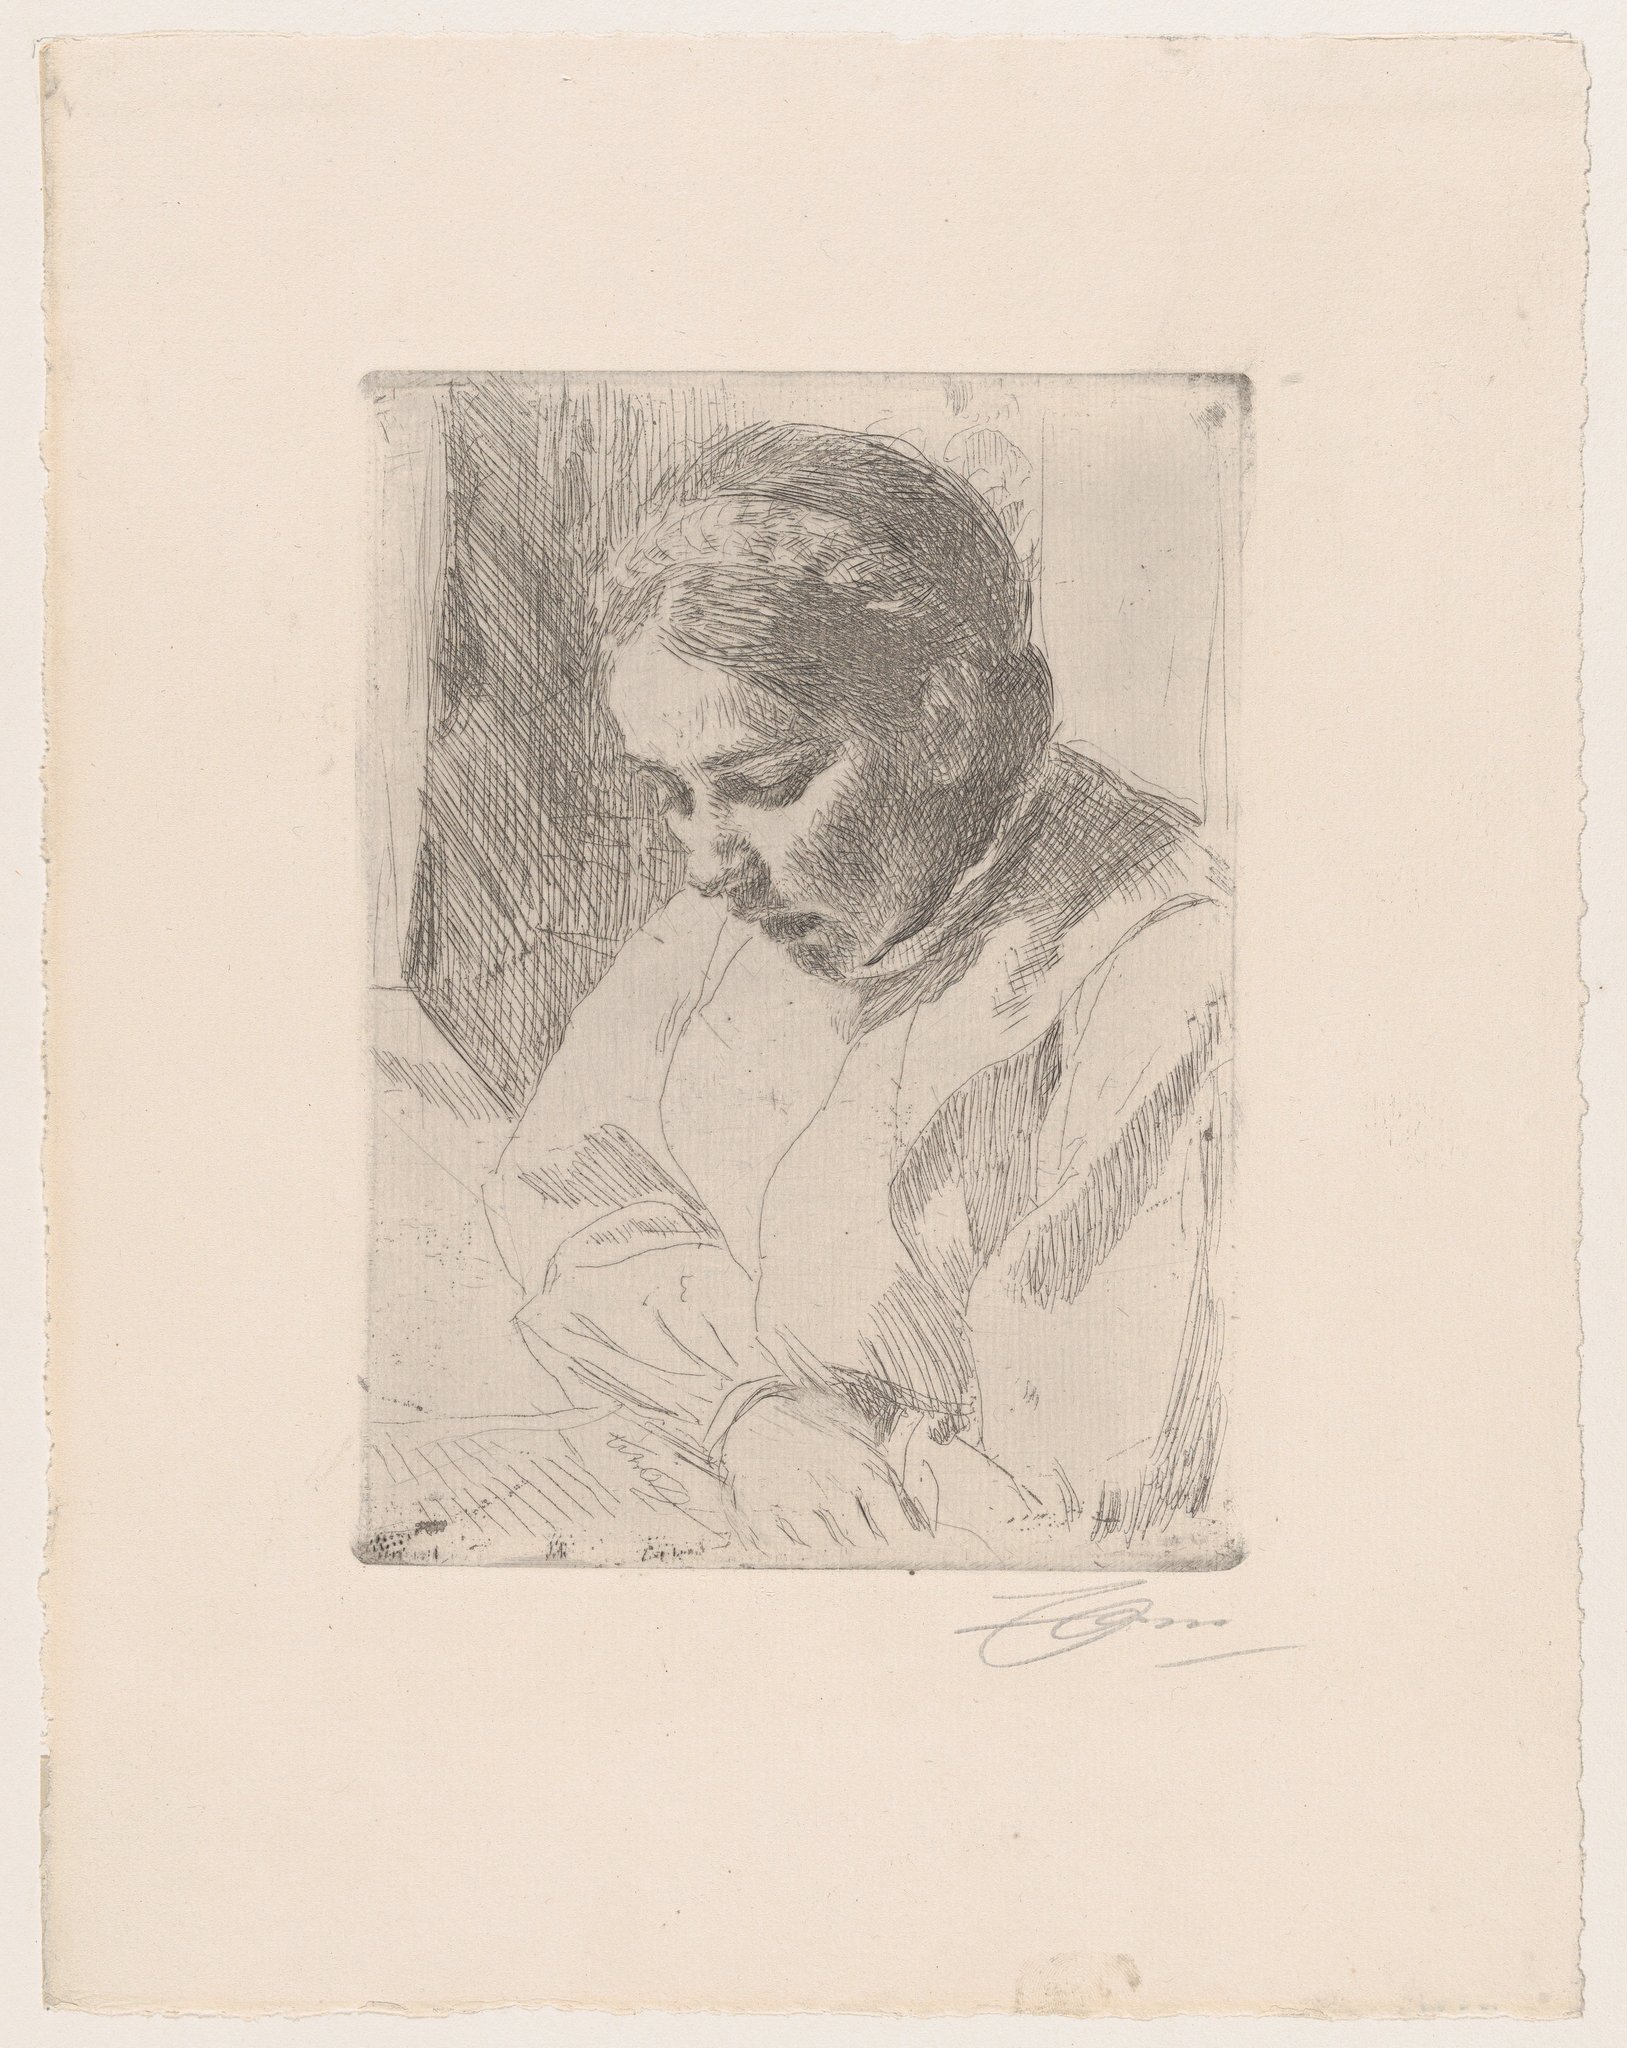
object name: print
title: At Prayer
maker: anders zorn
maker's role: artist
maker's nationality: swedish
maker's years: 1860-1920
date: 1912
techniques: etching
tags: women